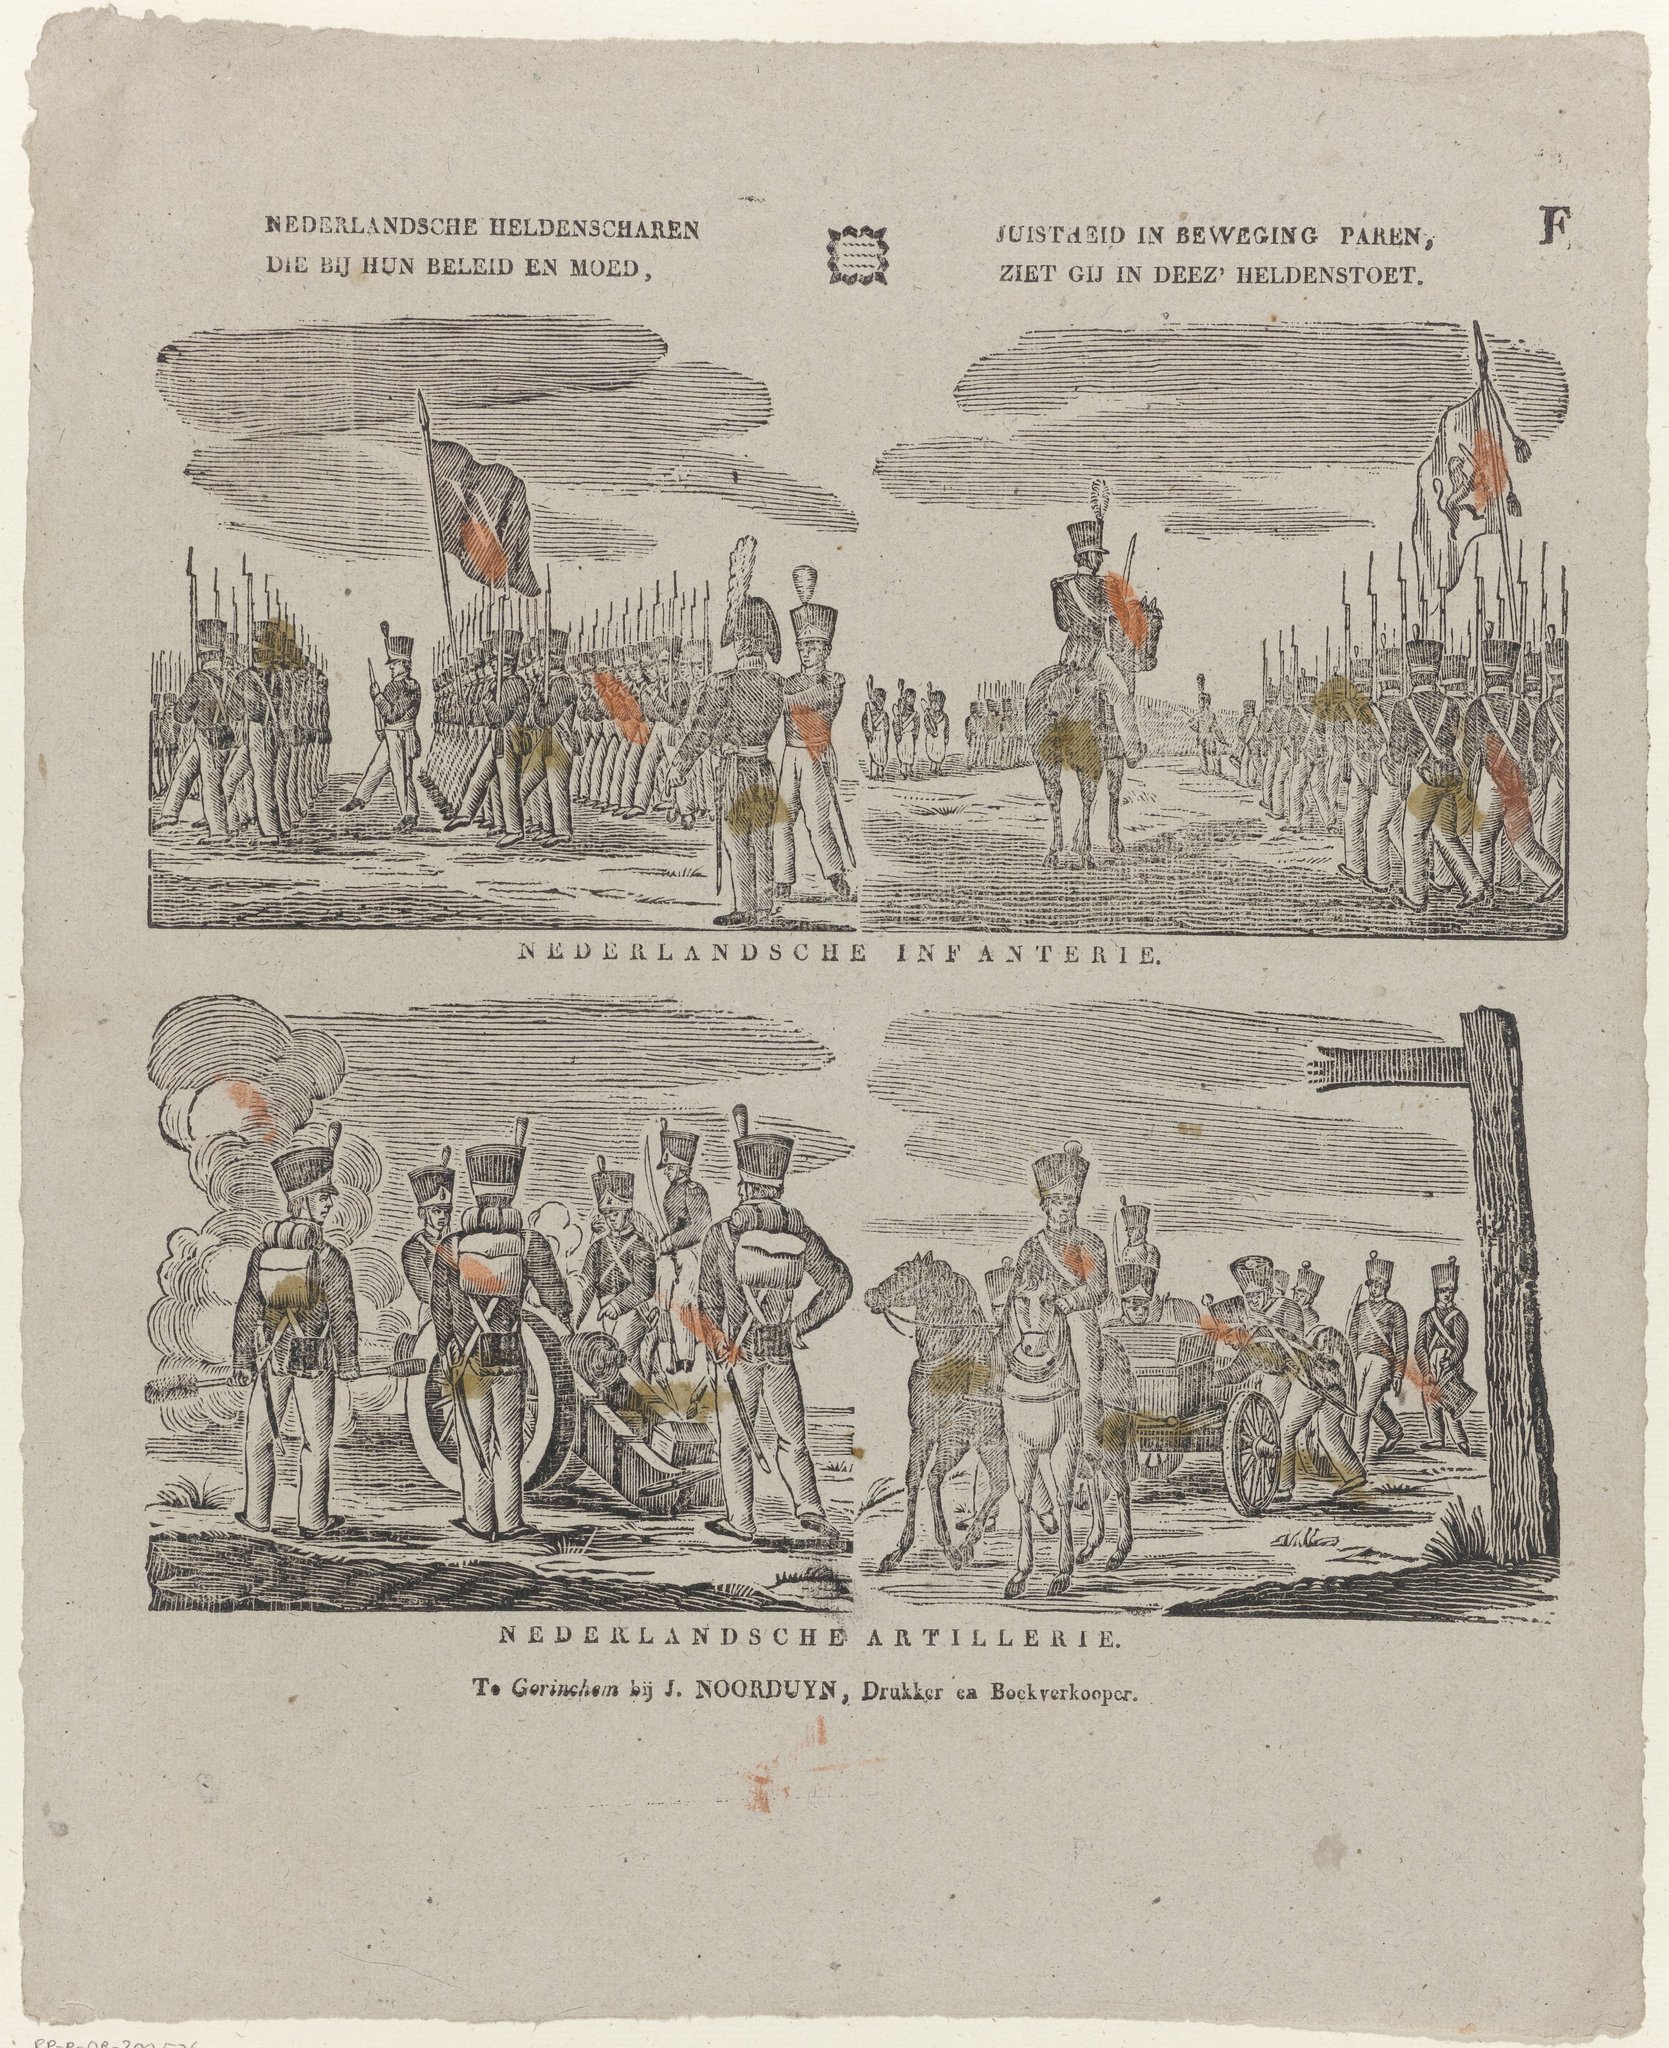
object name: print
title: Nederlandsche heldenscharen / Die bij hun beleid en moed, / Juistheid in beweging paren, / Ziet gij in deez' heldenstoet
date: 1819-1840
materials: paper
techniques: colour, letterpress printing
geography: gorinchem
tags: artillery range, firing range, shooting range ~ military training, private soldier (+ infantry), weapons, the soldier; the soldier's life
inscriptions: collector's mark: Lugt 2760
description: Blad met 4 voorstellingen van de Nederlandse infanterie marcherend in rijen, de Nederlandse artillerie die een kanon afvuurt en soldaten die een kar vol laden. Gemerkt rechtsboven: F.